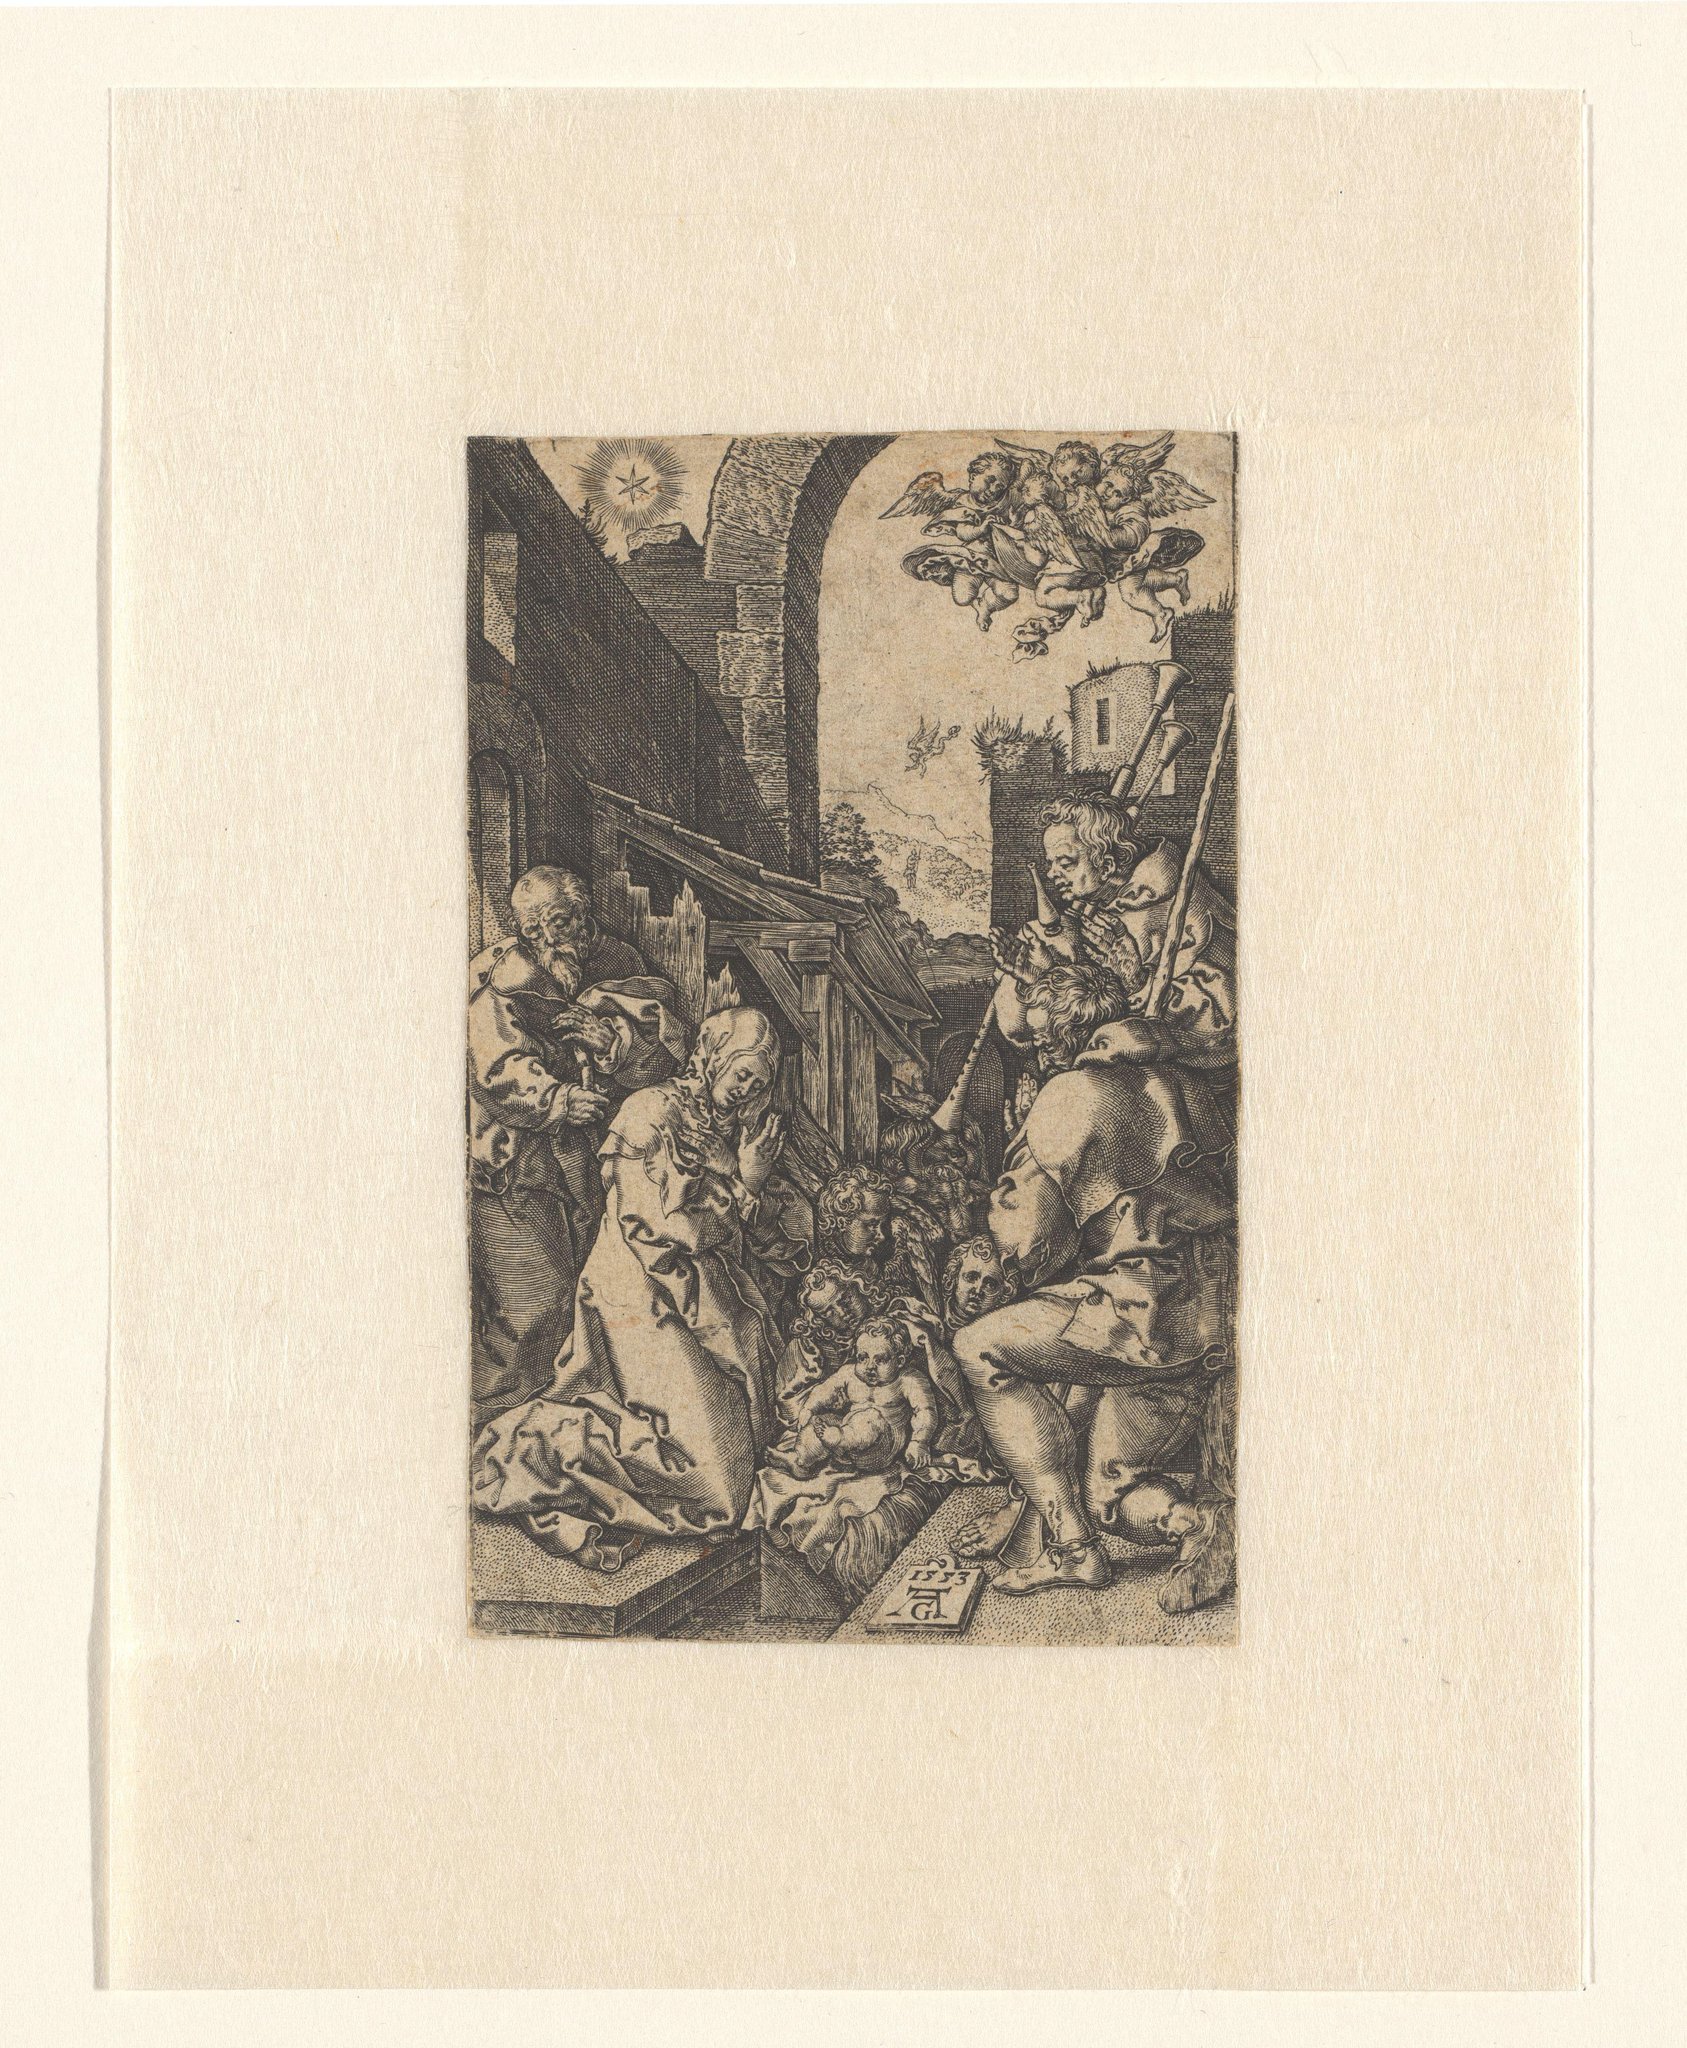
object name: print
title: Aanbidding door de herders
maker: heinrich aldegrever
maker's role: draughtsman, print maker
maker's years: 1502-1561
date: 1553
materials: paper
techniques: engraving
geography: germany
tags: adoration of the christ-child by the shepherds; mary and joseph present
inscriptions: date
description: Het Christuskind gelegen in een kribbe, met rondom Maria en Jozef, engelen en twee herders, waarvan één met een doedelzak. In het landschap op de achtergrond de aankondiging aan de herders door een engel.